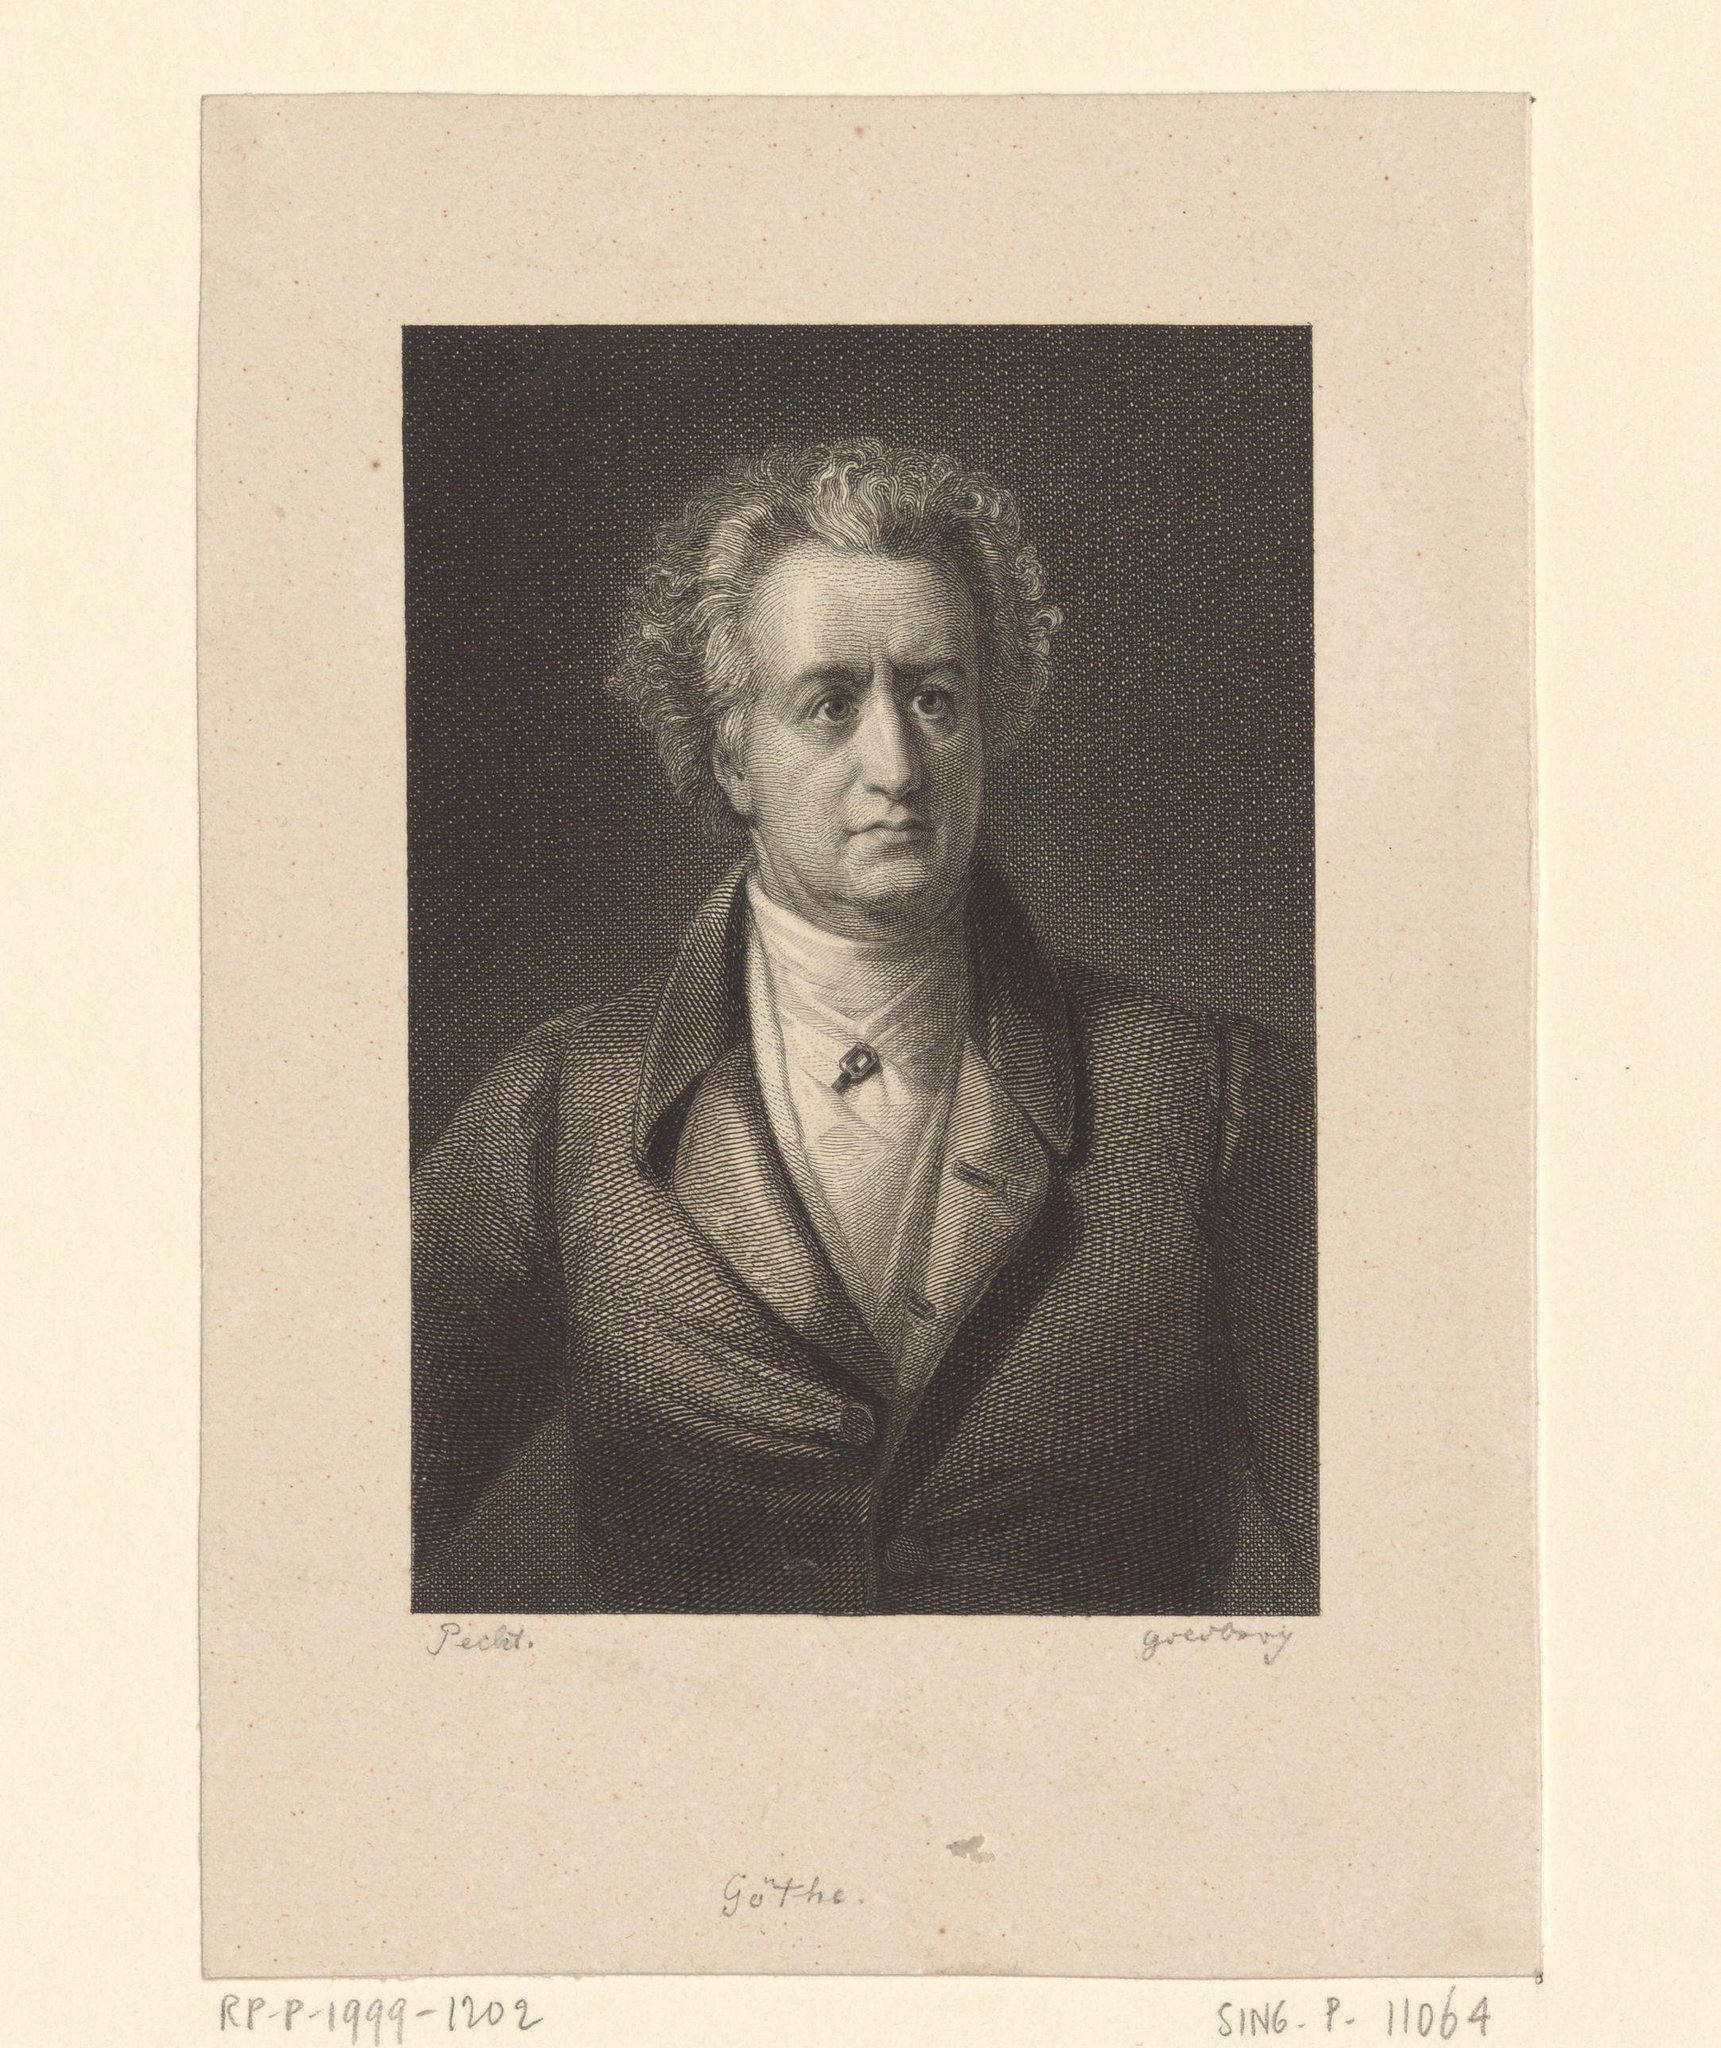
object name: print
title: Portret van Johann Wolfgang von Goethe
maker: lazarus gottlieb sichling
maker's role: print maker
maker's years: 1812-1863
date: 1840-1877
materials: paper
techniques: engraving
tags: draughtsman, johann wolfgang von goethe, historical persons, portrait of a writer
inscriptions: collector's mark: Lugt 2228, collector's mark: Lugt 2760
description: Latere staat van prent gebruikt in: Pecht, Friedrich en Arthur von Ramberg. Goethe-Galerie. Charaktere aus Goethe’s Werken. Leipzig: Friedrich Arnold Brockhaus, 1877.